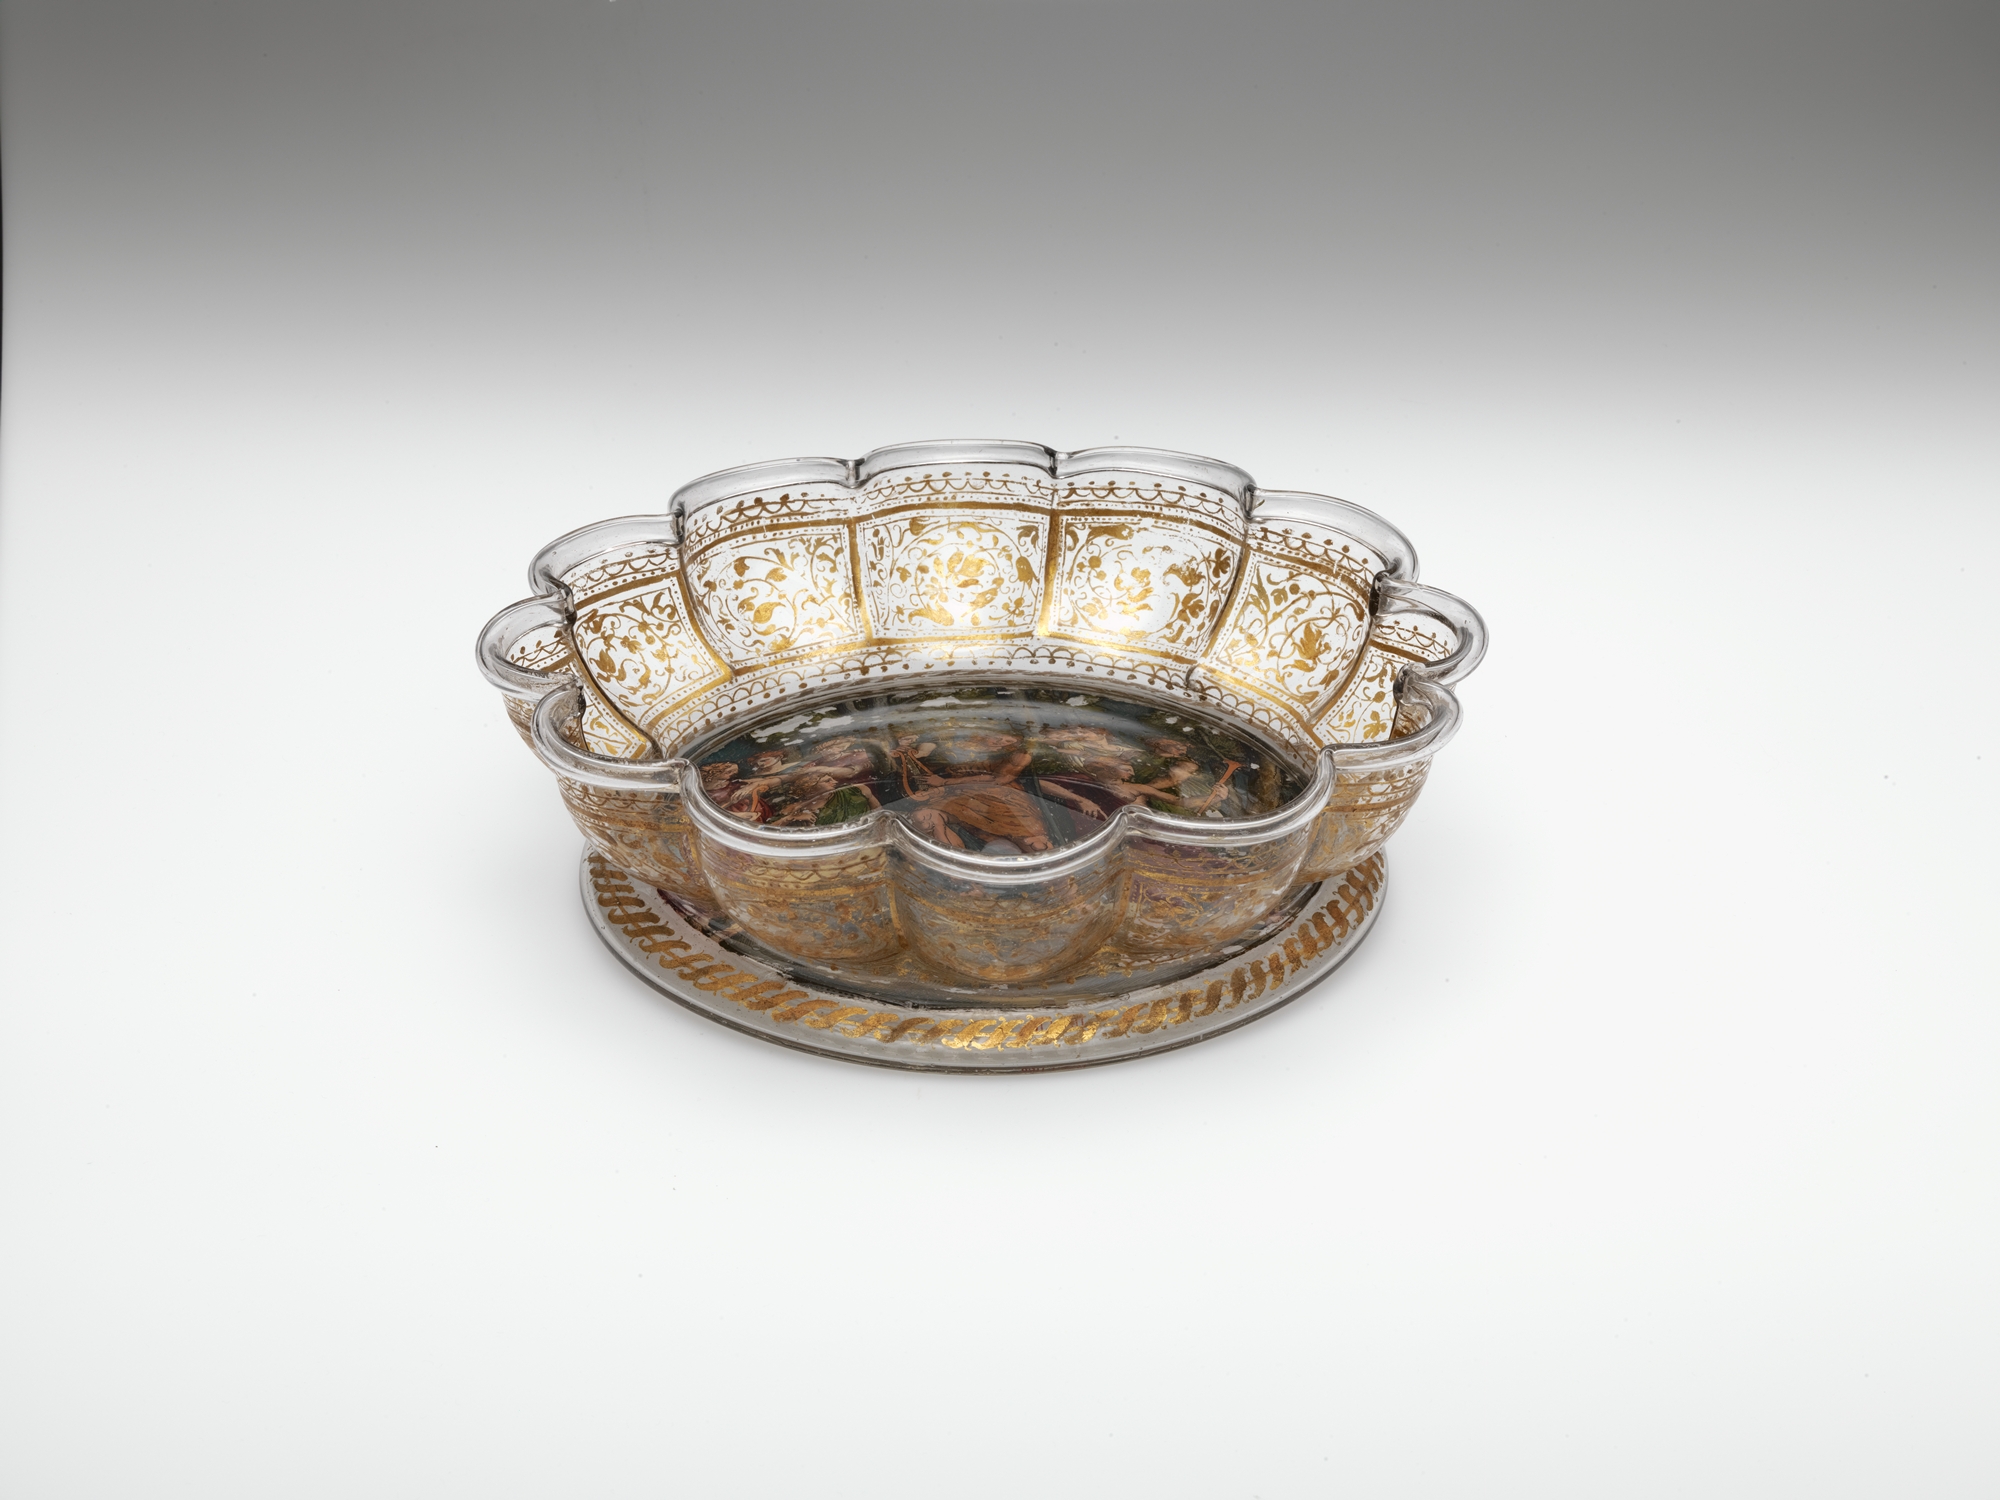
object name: dish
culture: venetian or façon de venise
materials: gilt, glass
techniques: glassblowing, painting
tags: men,women,lyres